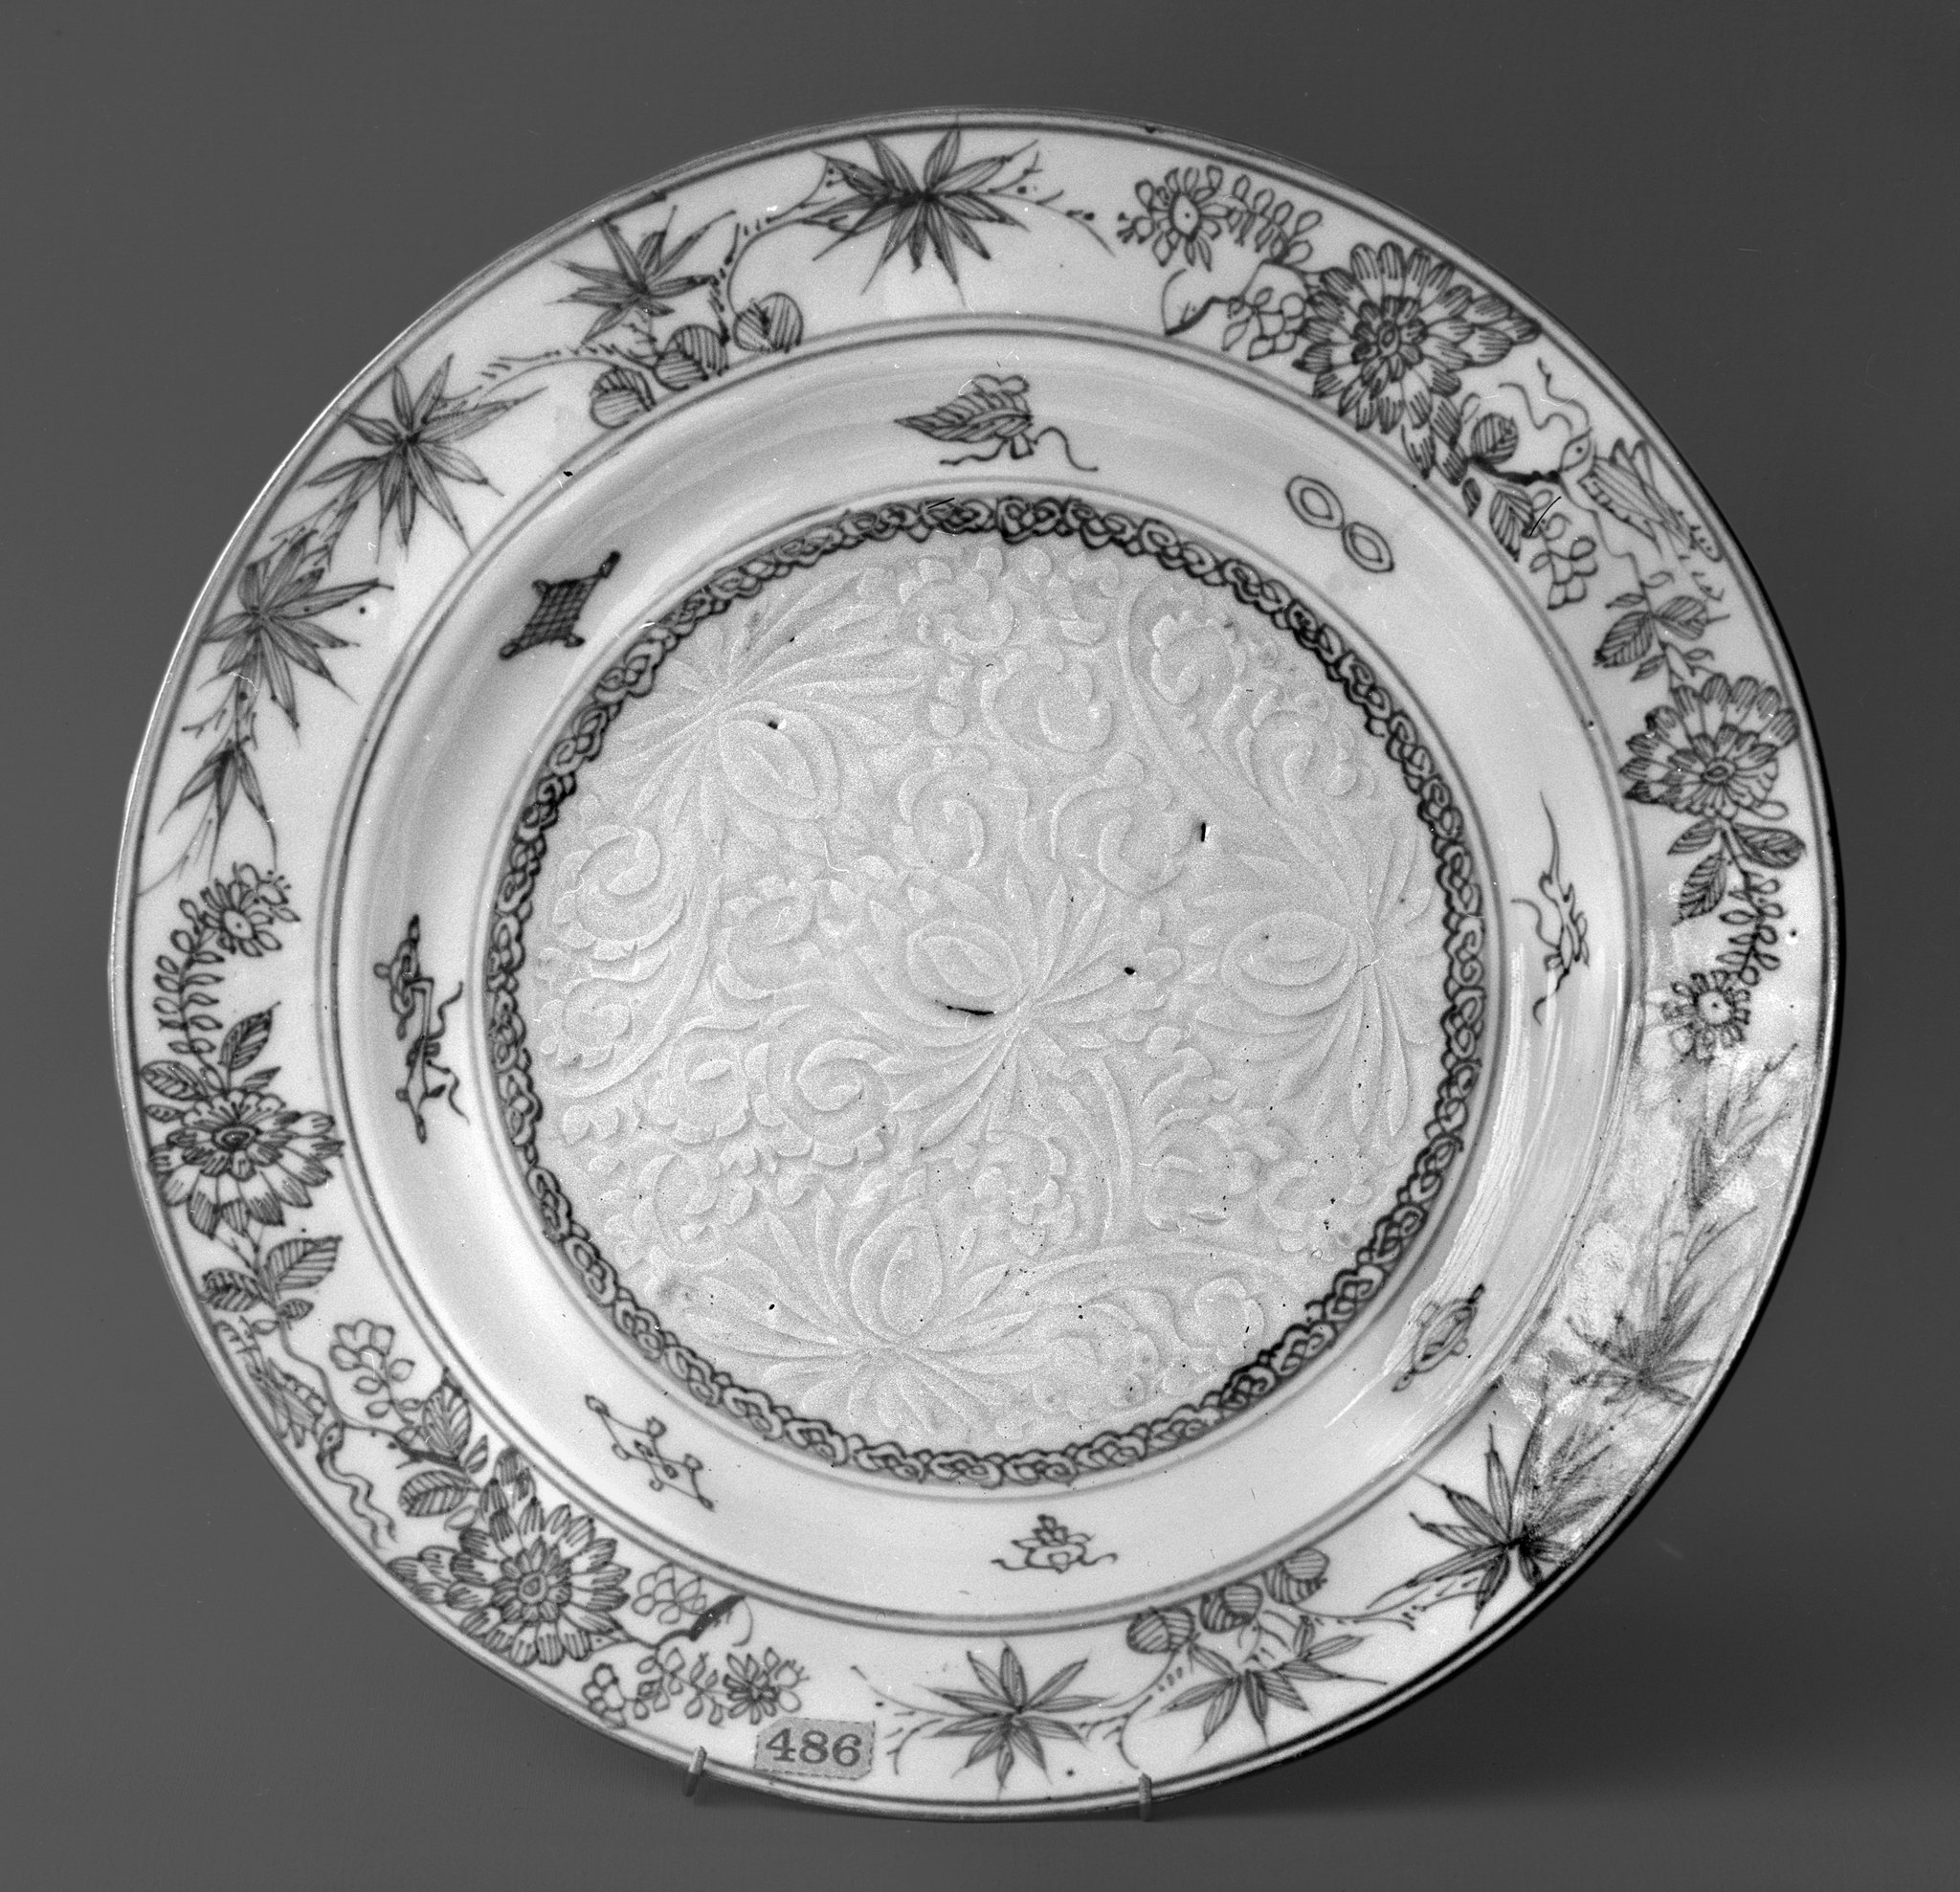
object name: plate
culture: chinese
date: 1701-1800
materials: gilt, porcelain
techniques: painting, underglaze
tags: flowers